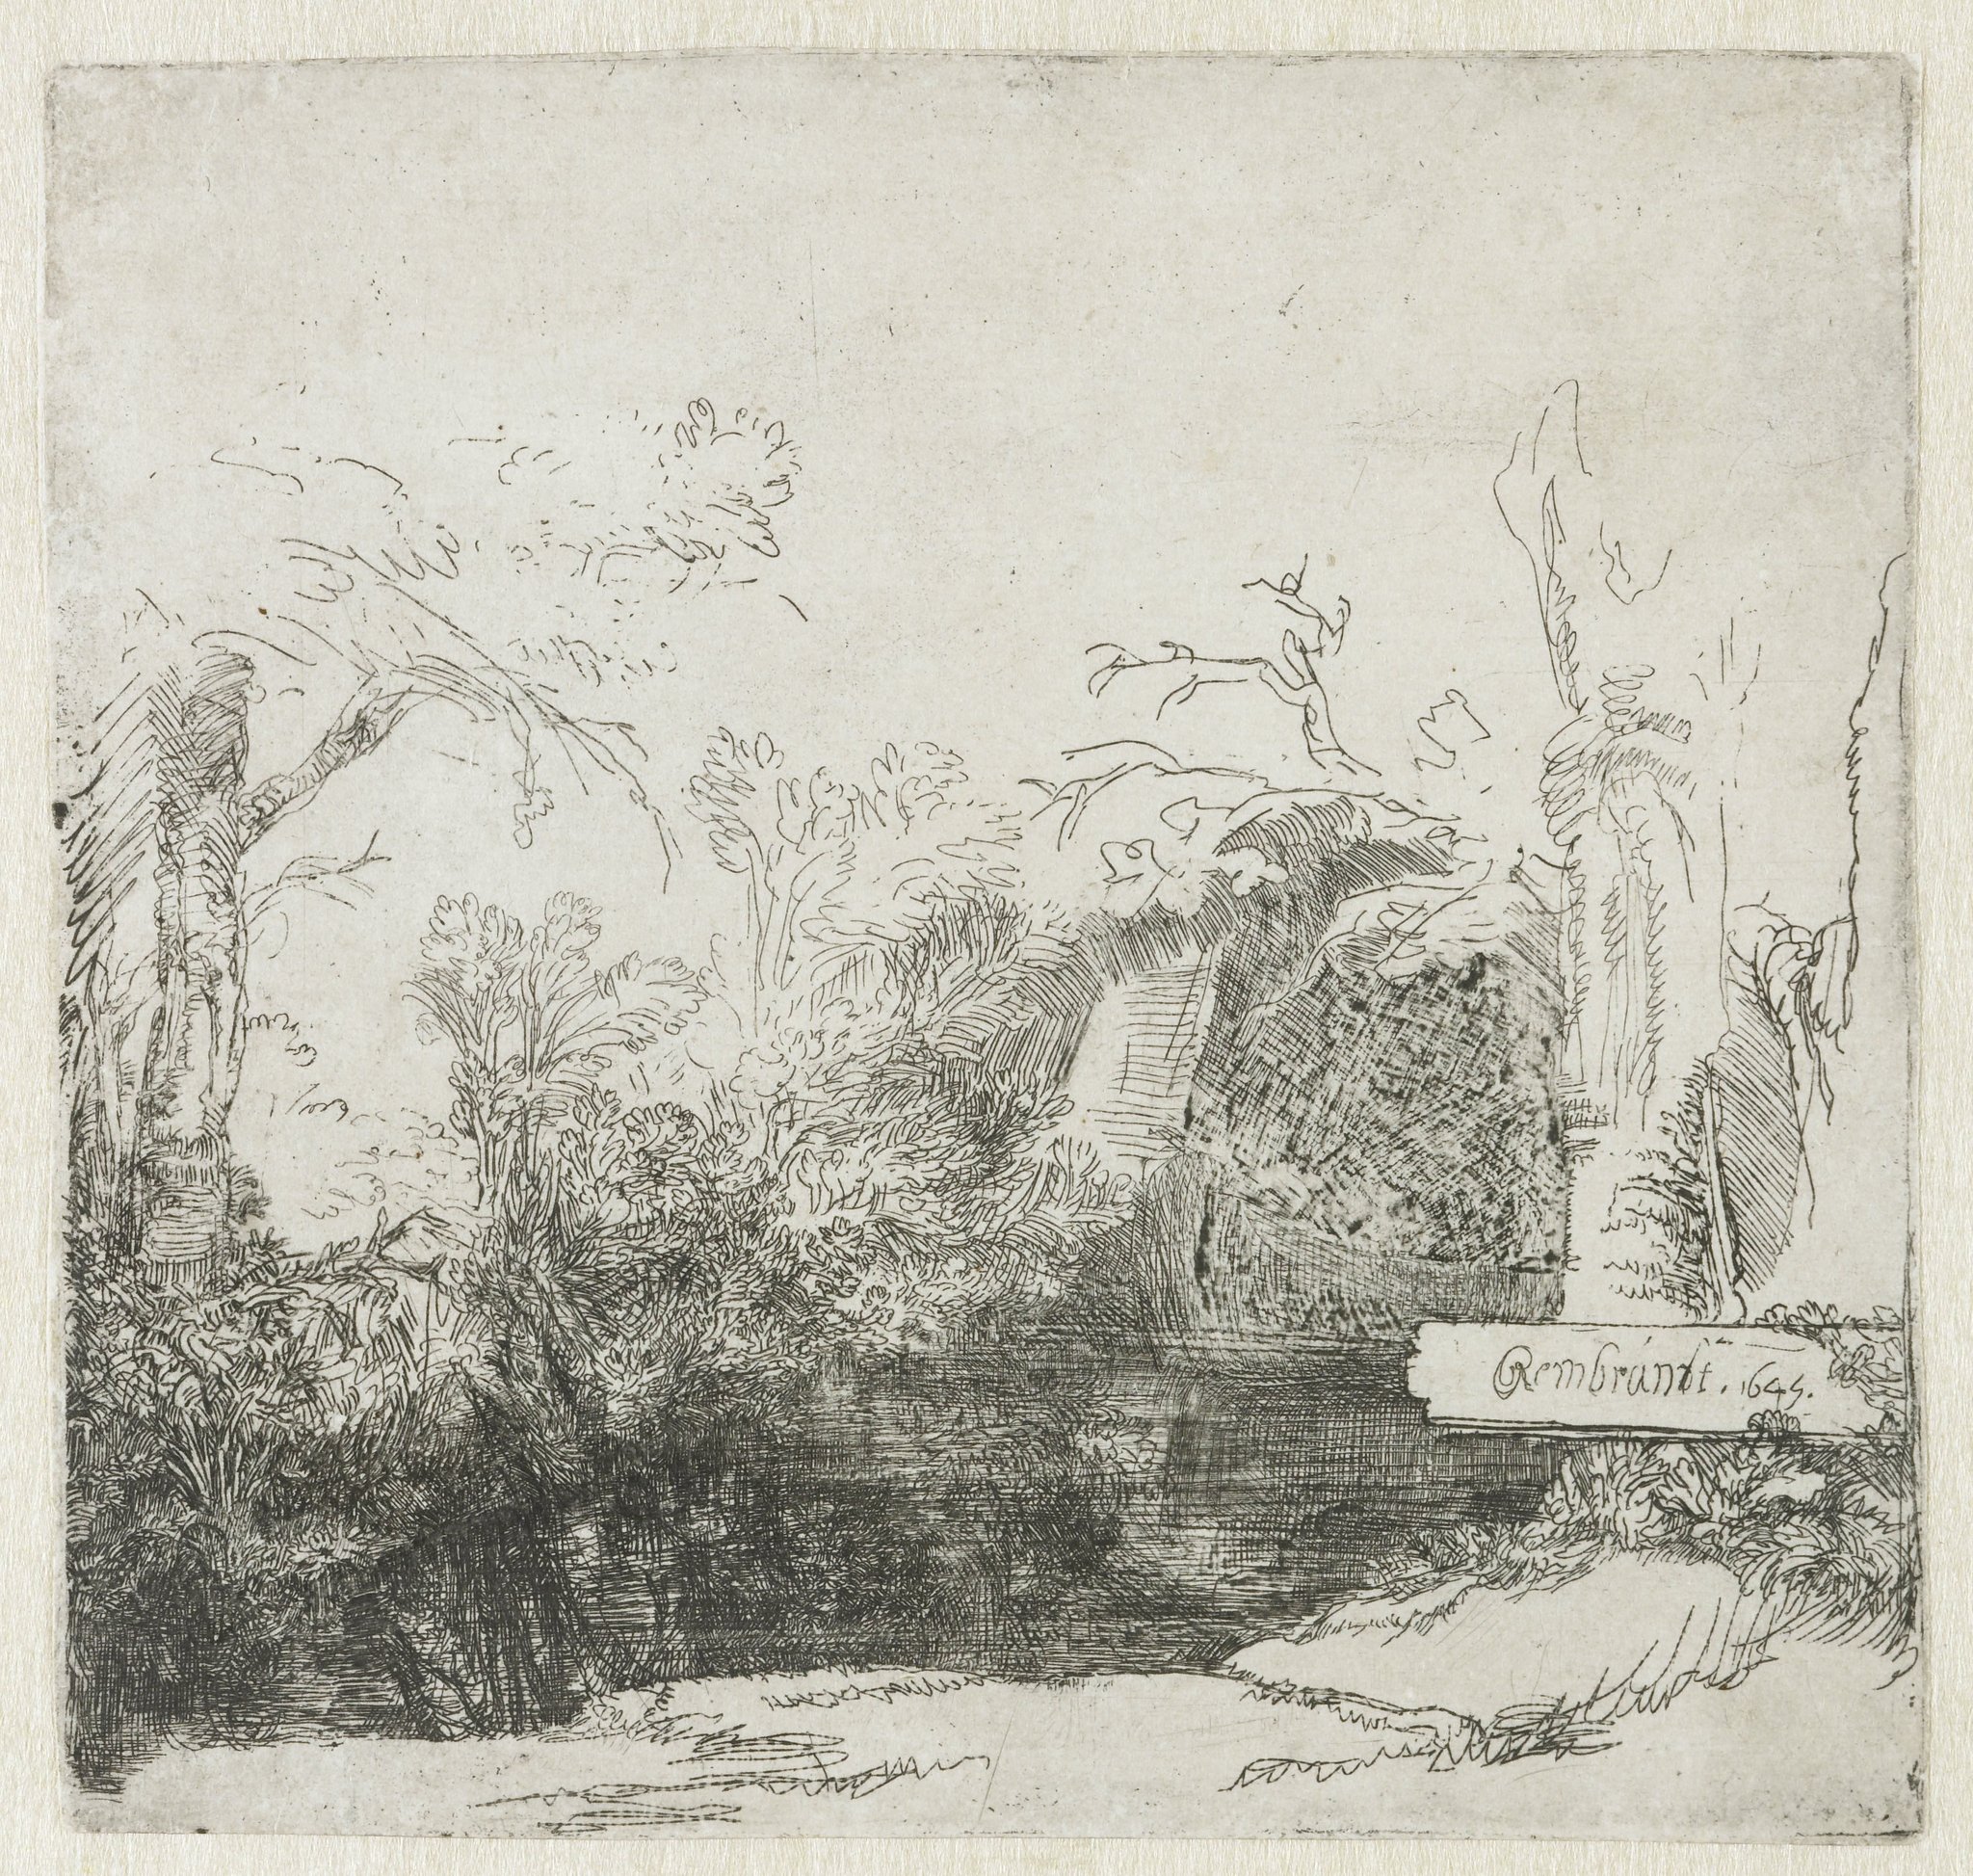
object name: print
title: A brook with a grotto and a boat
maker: rembrandt van rijn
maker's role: draughtsman, painter, print maker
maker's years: 1606-1669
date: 1645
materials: paper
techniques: drypoint, etching, intaglio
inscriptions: signature and date: ‘Rembrandt . 1645’, mark: Lugt 2228 a